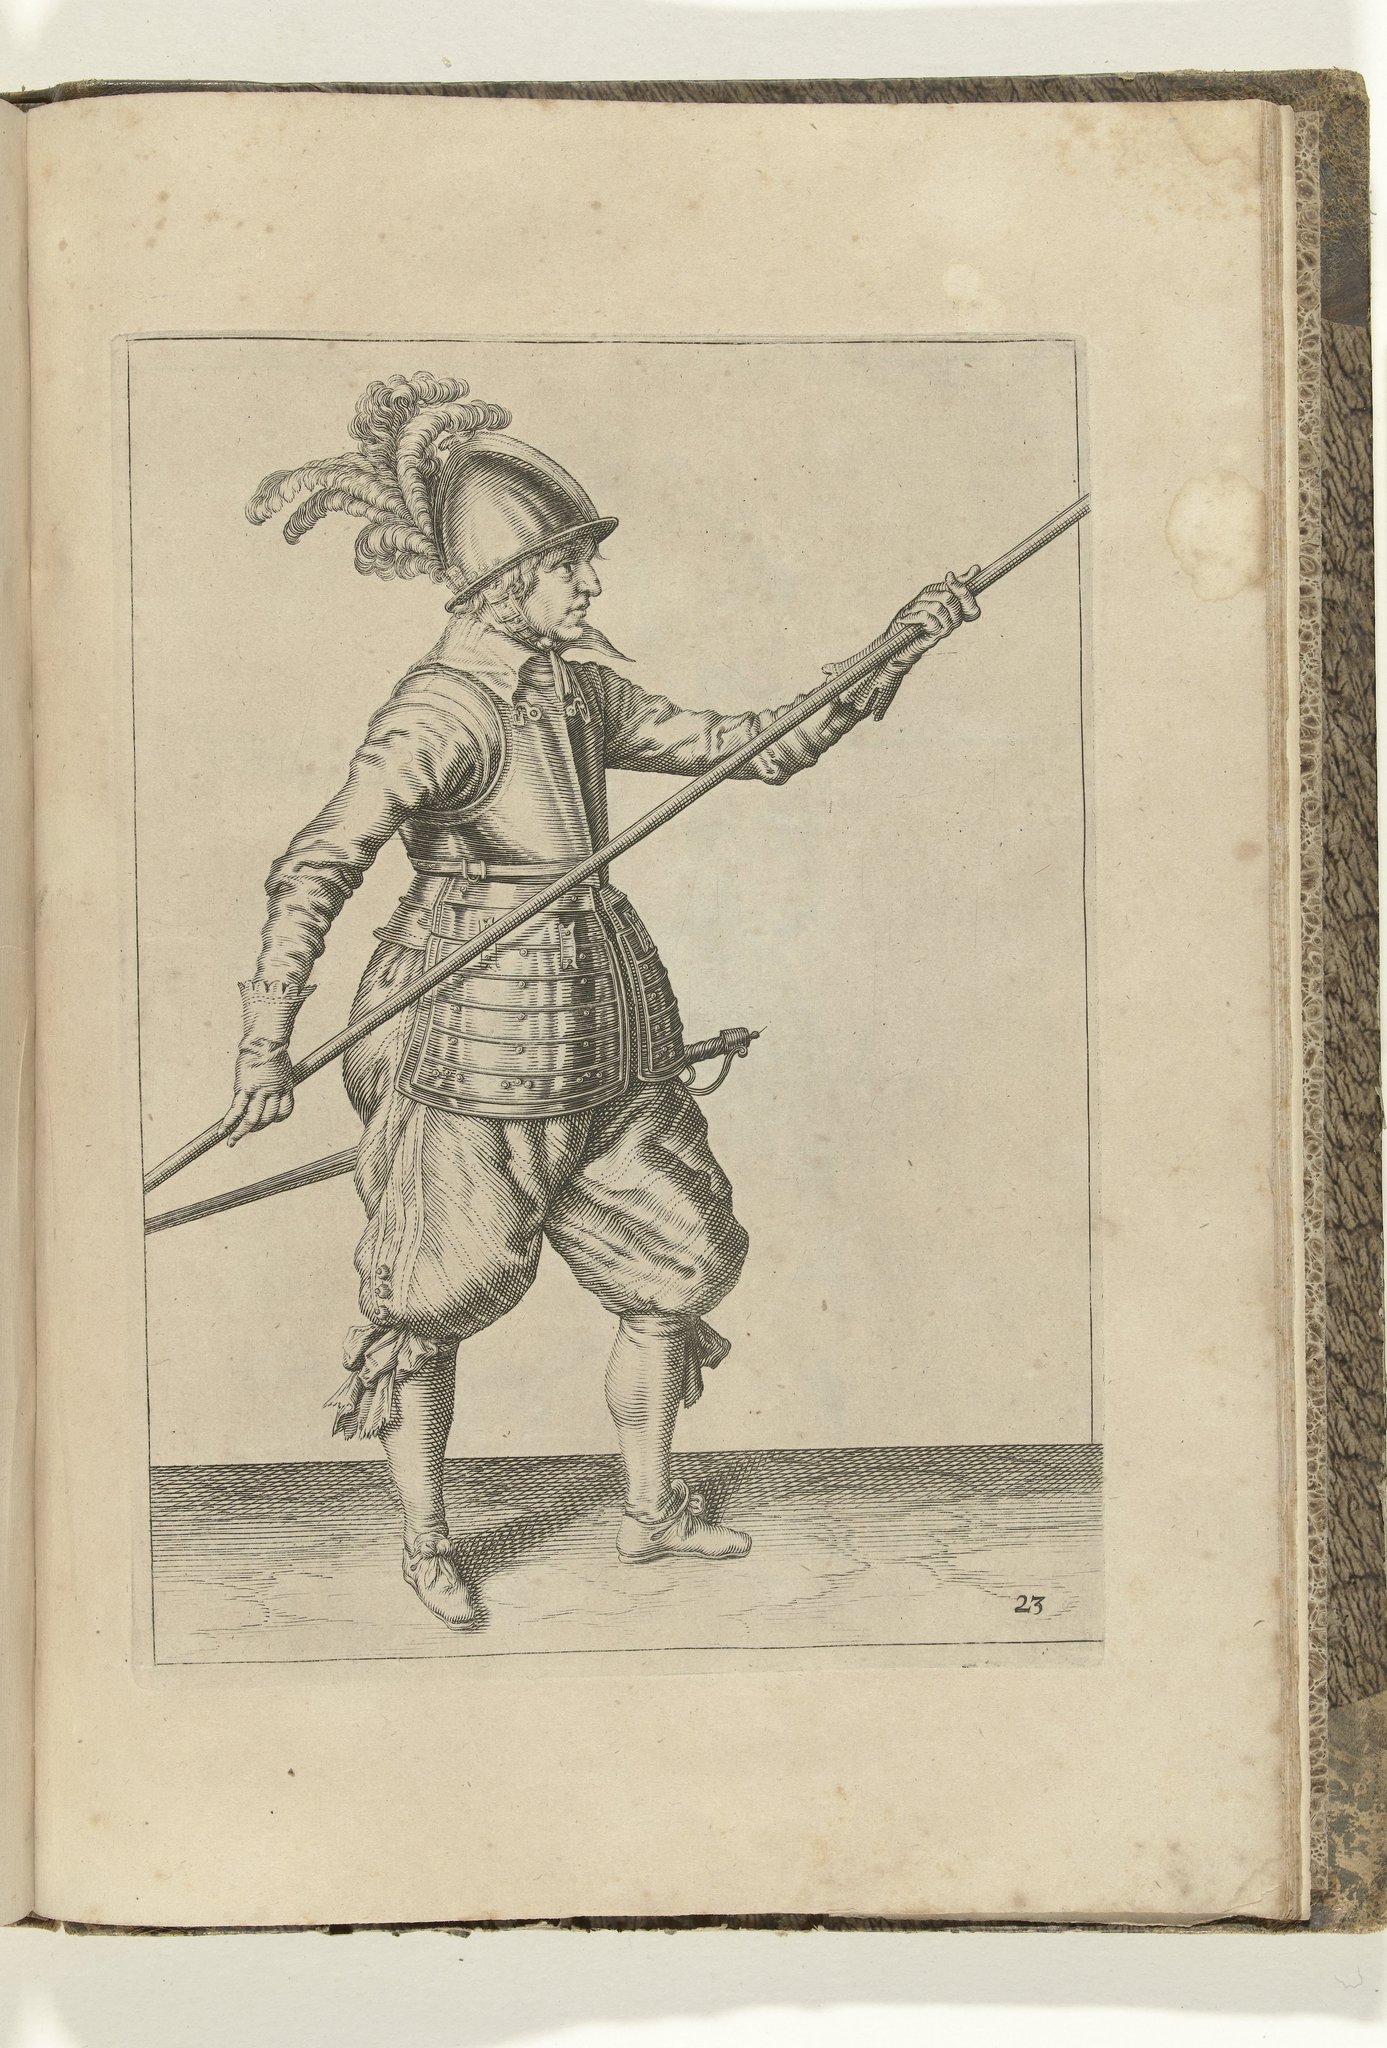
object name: print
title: Soldaat die zijn spies naar voren steekt door zijn rechterhand over te brengen van de punt naar de voet van het wapen (nr. 23), ca. 1600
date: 1597-1608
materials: paper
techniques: engraving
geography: northern netherlands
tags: maurice (prince of orange), handling of weapons ~ military training, weapons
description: Een soldaat, ten voeten uit, naar rechts, die zijn spies (lans) naar voren steekt door zijn rechterhand over te brengen van de punt naar de voet van het wapen (nr. 23), ca. 1600. Plaat 23 in de instructies voor het hanteren van de spies: Enseignement brief; et succint sur les portraitz figurez, touchant l'usage, de tout ce qu'un Soldat doibt faire au maniement de la Pique. Onderdeel van de illustraties in een Franse editie van J. de Gheyns Wapenhandelinghe: J. de Gheyn, Maniement d'armes, d'arquebuses, mousquetz et piques : en conformité de l'ordre de Mour le Prince Maurice, Prince d'Orange, Amsterdam 1608. Krijgswezen rond 1600.